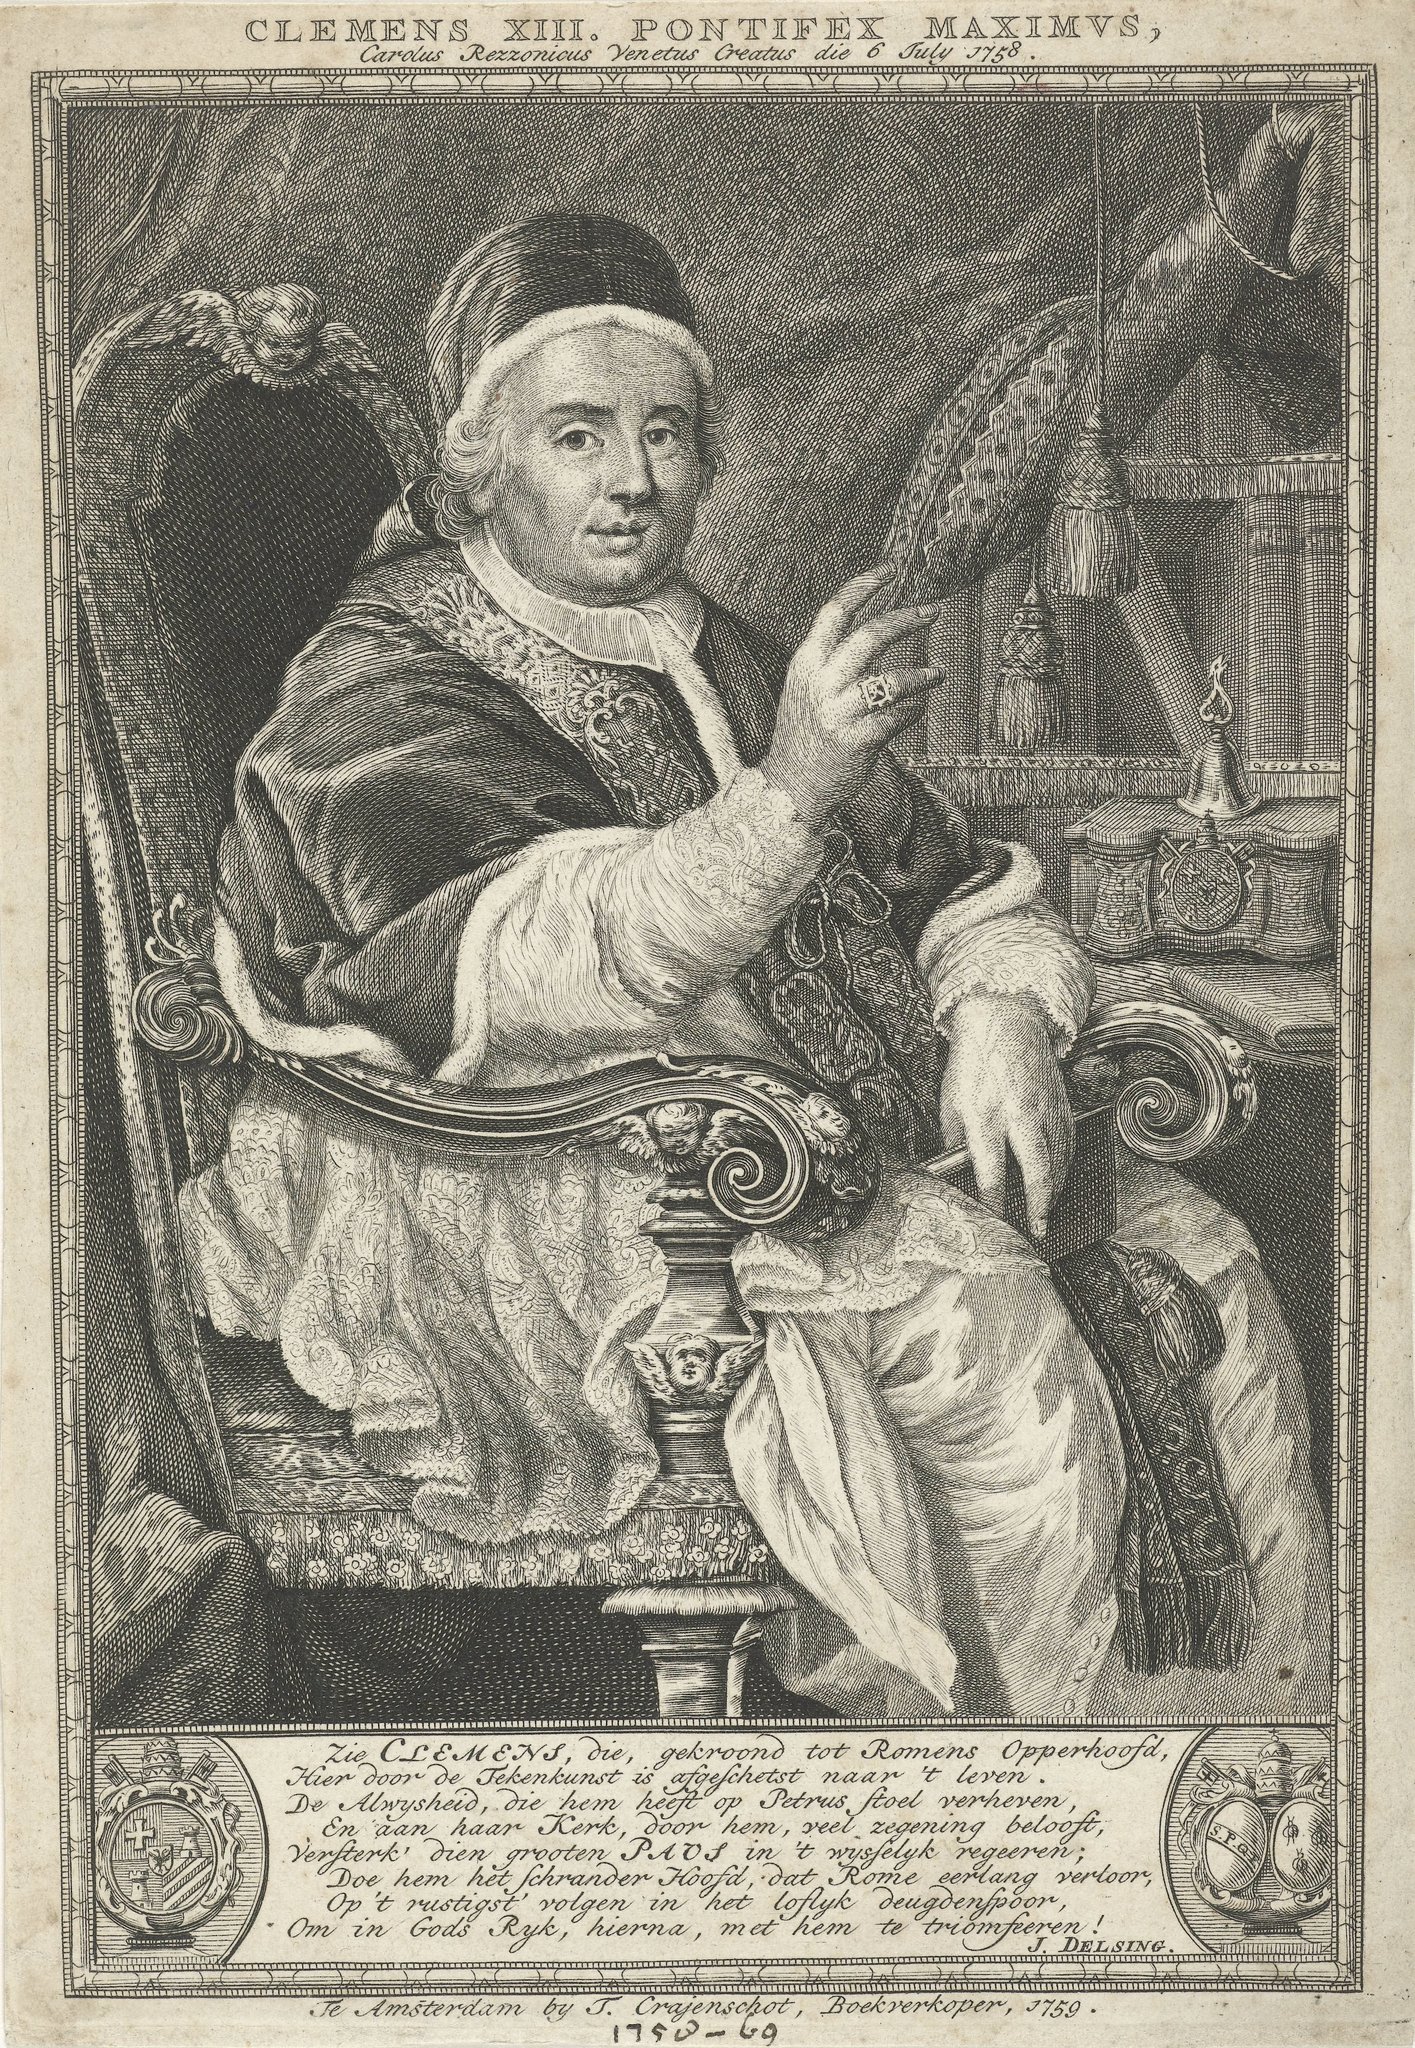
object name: print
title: Portret van paus Clemens XIII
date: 1759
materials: paper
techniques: etching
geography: amsterdam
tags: clemens xiii, pope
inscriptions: collector's mark: Lugt 2228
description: Paus Clemens XIII gehuld in het pauselijk gewaad, op het hoofd een camauro, zittend in een leunstoel. Met zijn rechterhand maakt hij een zegenend gebaar. Onder de voorstelling staat een achtregelige tekst in het Nederlands, geflankeerd door twee wapenschilden.